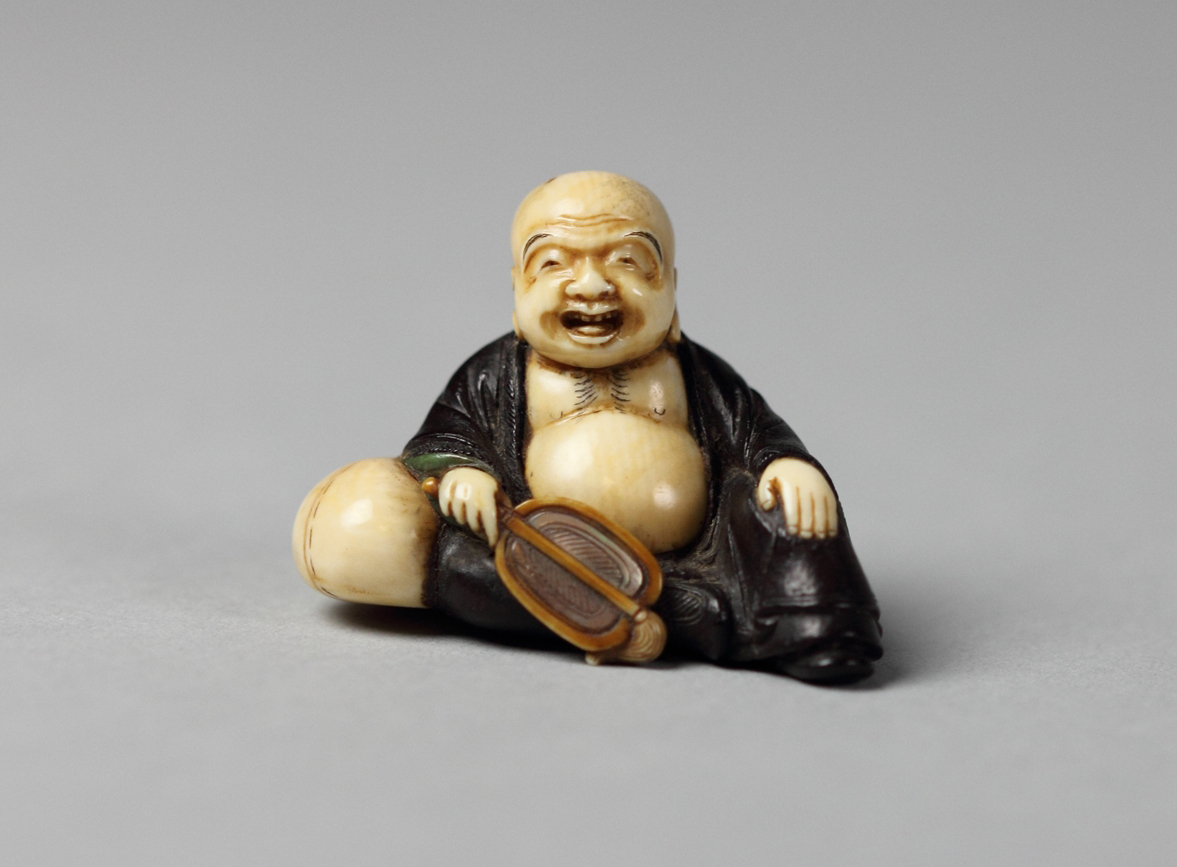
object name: netsuke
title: Netsuke of Hotei with a Fan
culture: japanese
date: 1801-1900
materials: ivory, wood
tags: fans,men